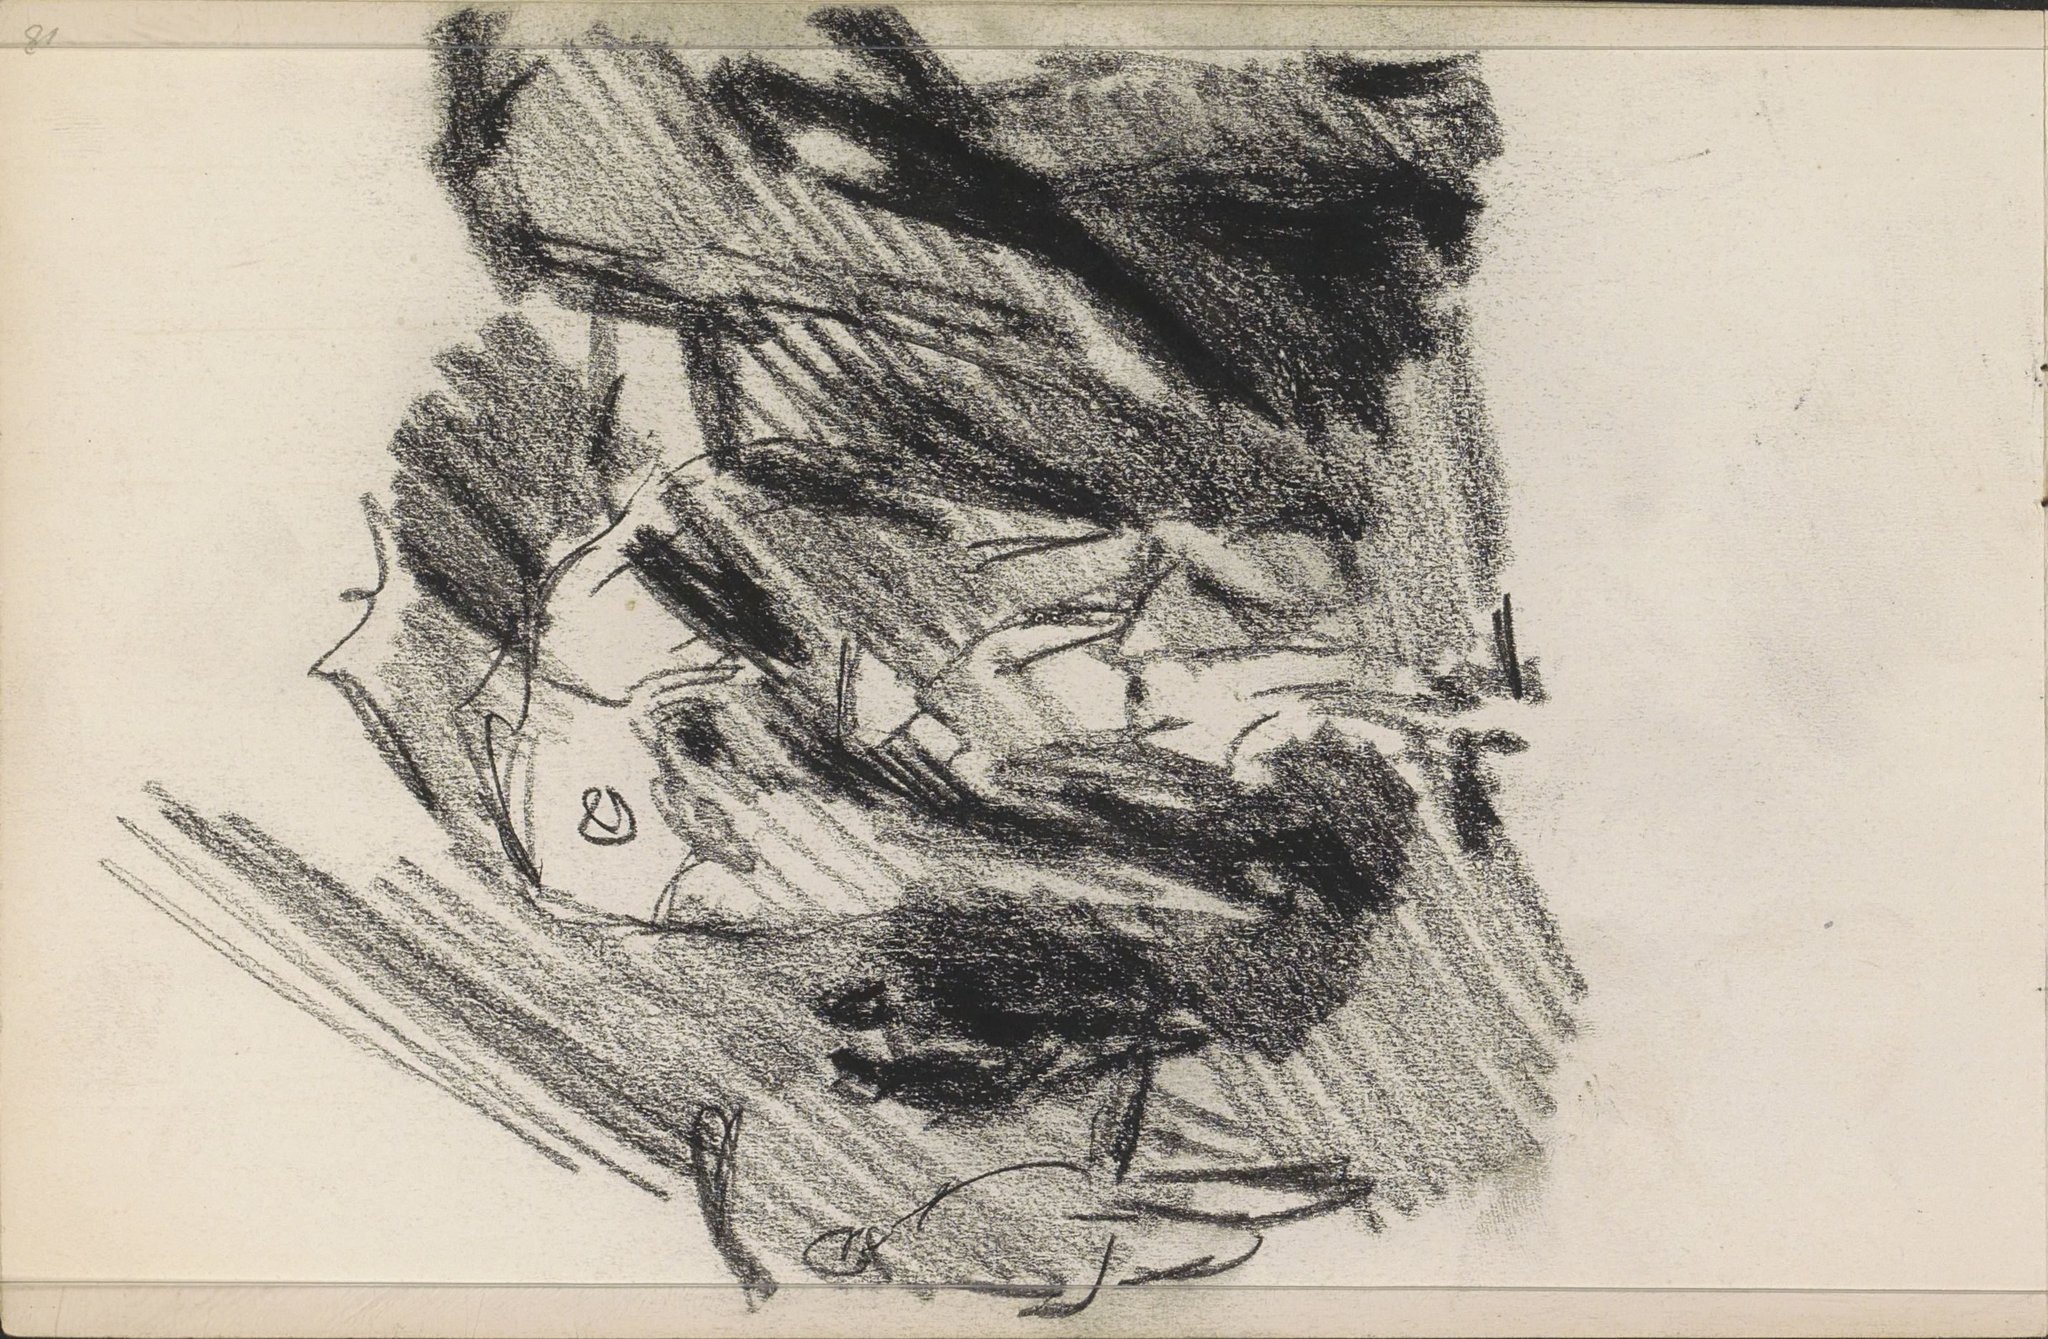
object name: sketchbook leaf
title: Staande figuren rond olifanten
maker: isaac israels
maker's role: draughtsman, painter, print maker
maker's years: 1865-1934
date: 1875-1934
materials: chalk, paper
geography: paris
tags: elephants (circus performance), adult man (+ standing), trunked animals: elephant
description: Mogelijk verzorgers of circusartiesten. Blad 5 verso uit schetsboek LI met 11 bladen.